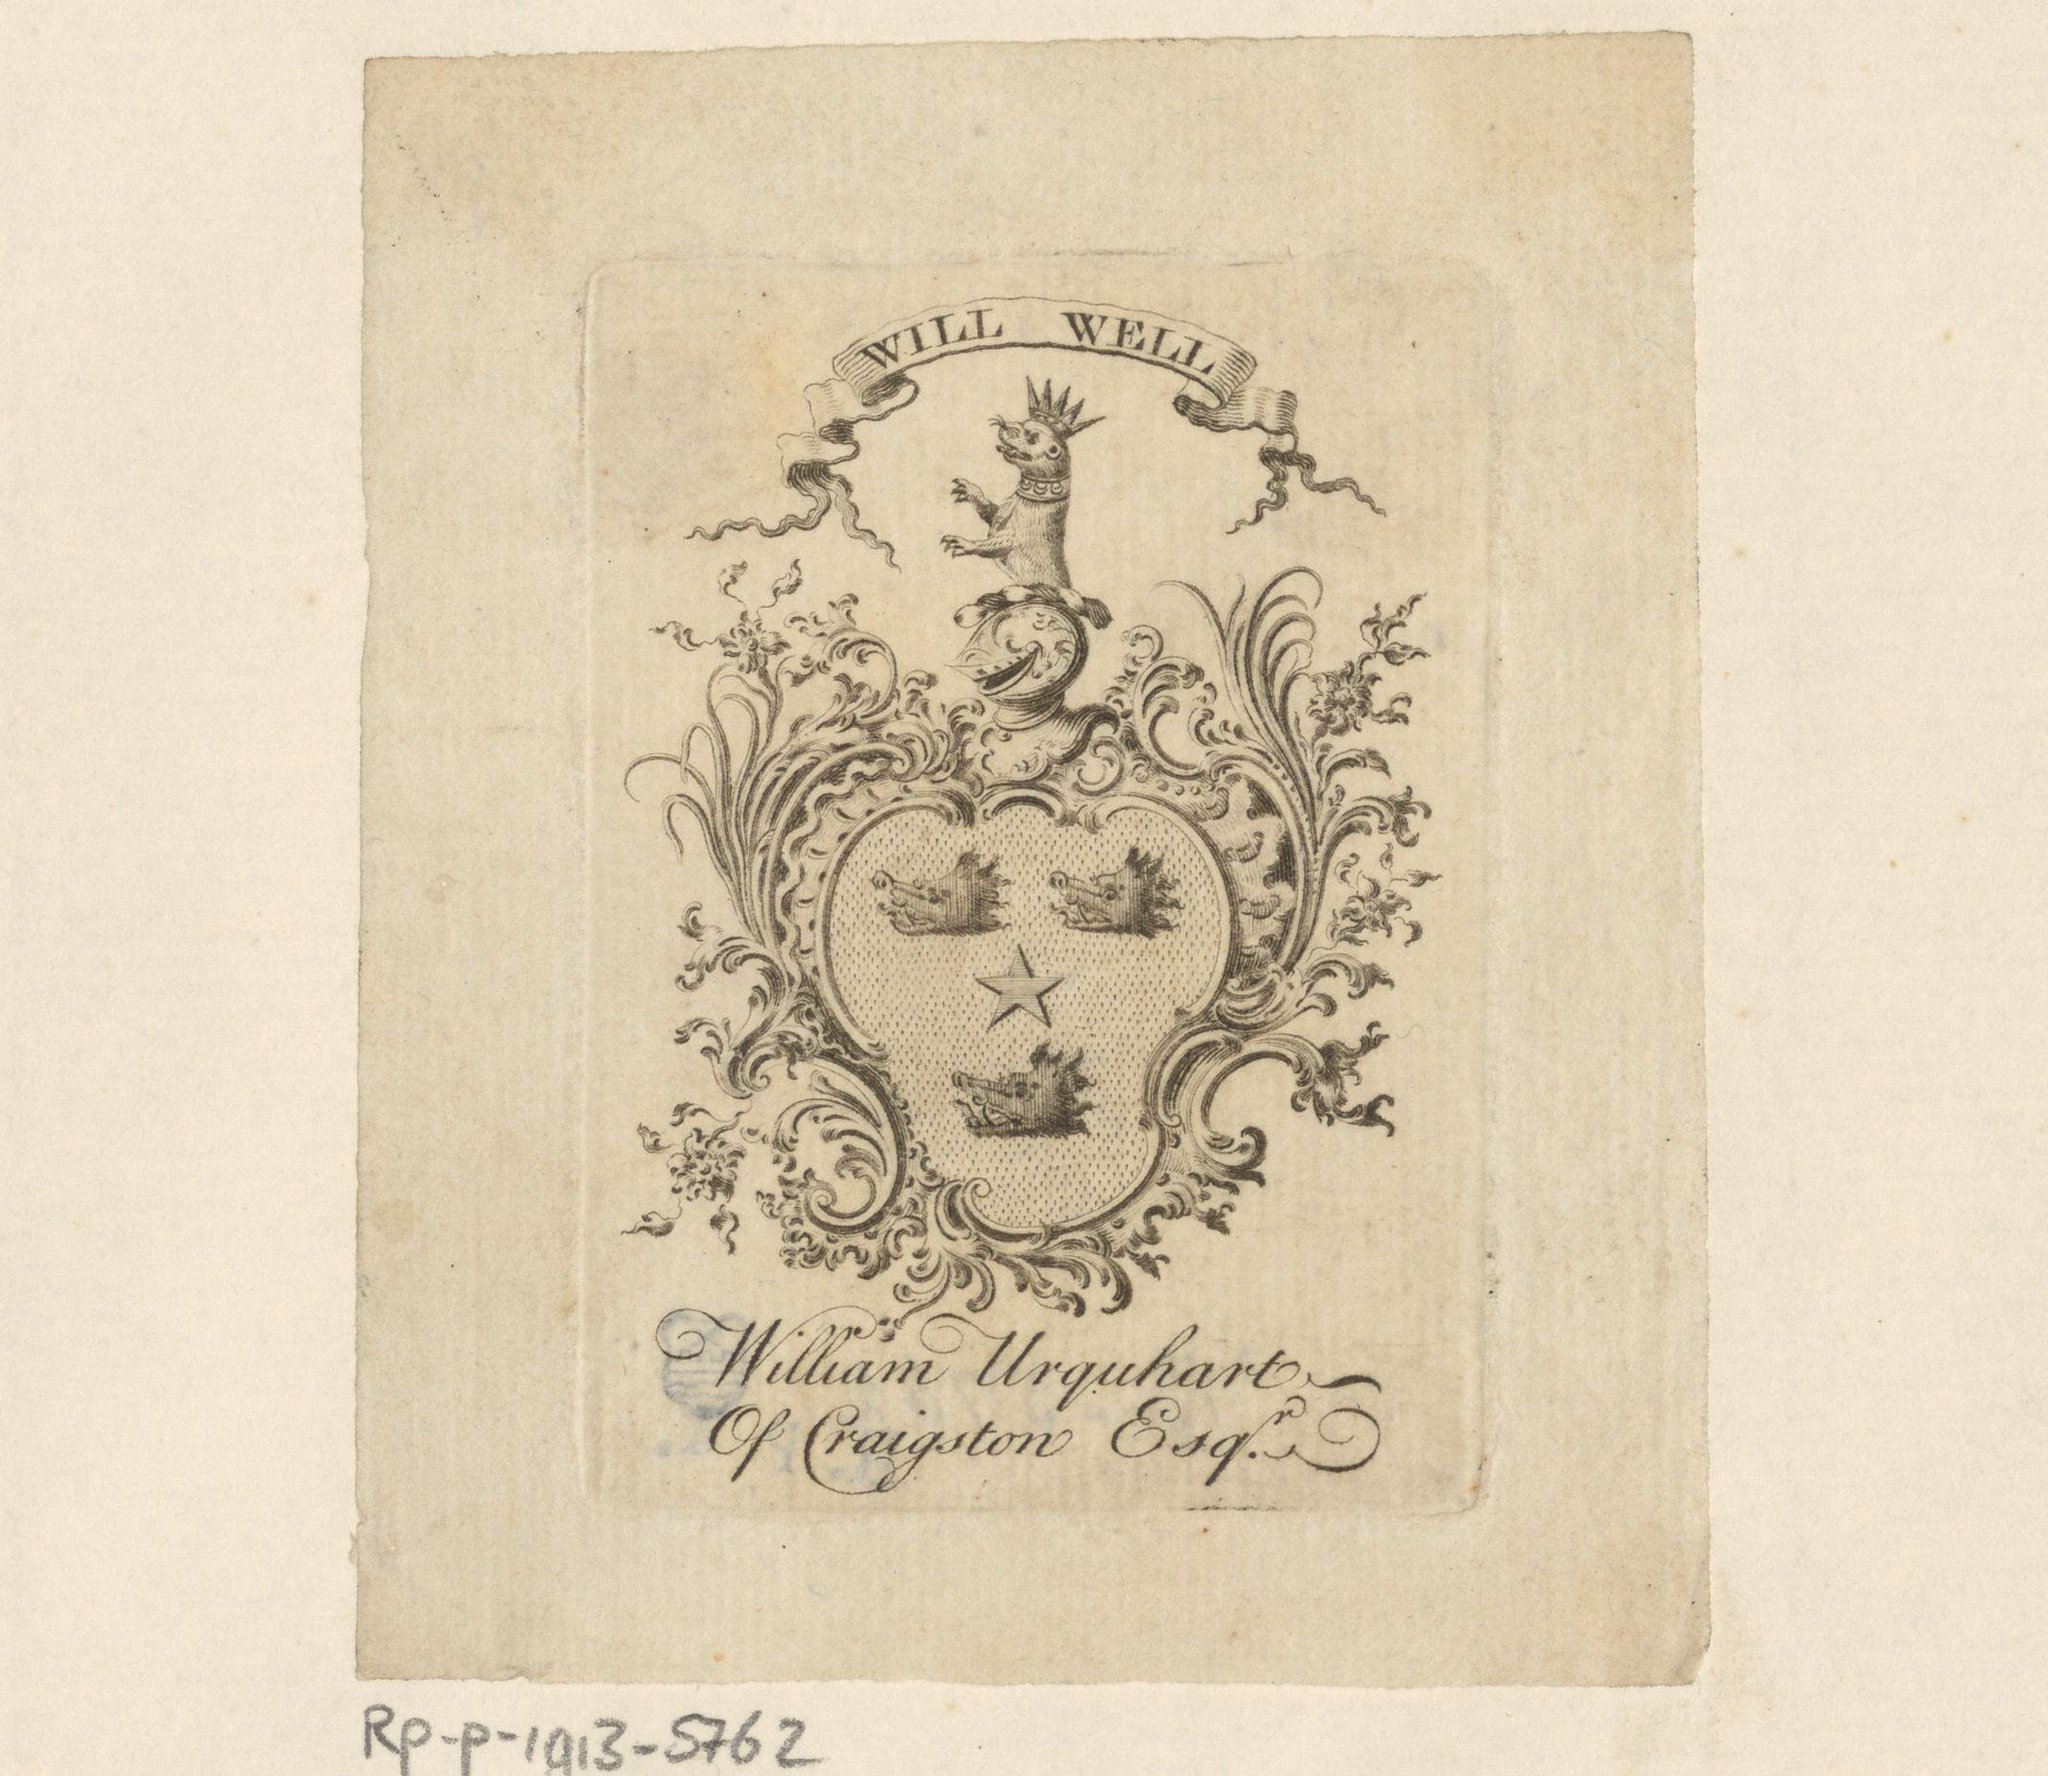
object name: bookplate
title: Ex libris van William Urquhart of Craigston Esqr.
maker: Anonymous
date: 1811-1847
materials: paper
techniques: engraving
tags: armorial bearing, heraldry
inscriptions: collector's mark: Lugt 2760, collector's mark: Lugt 2233